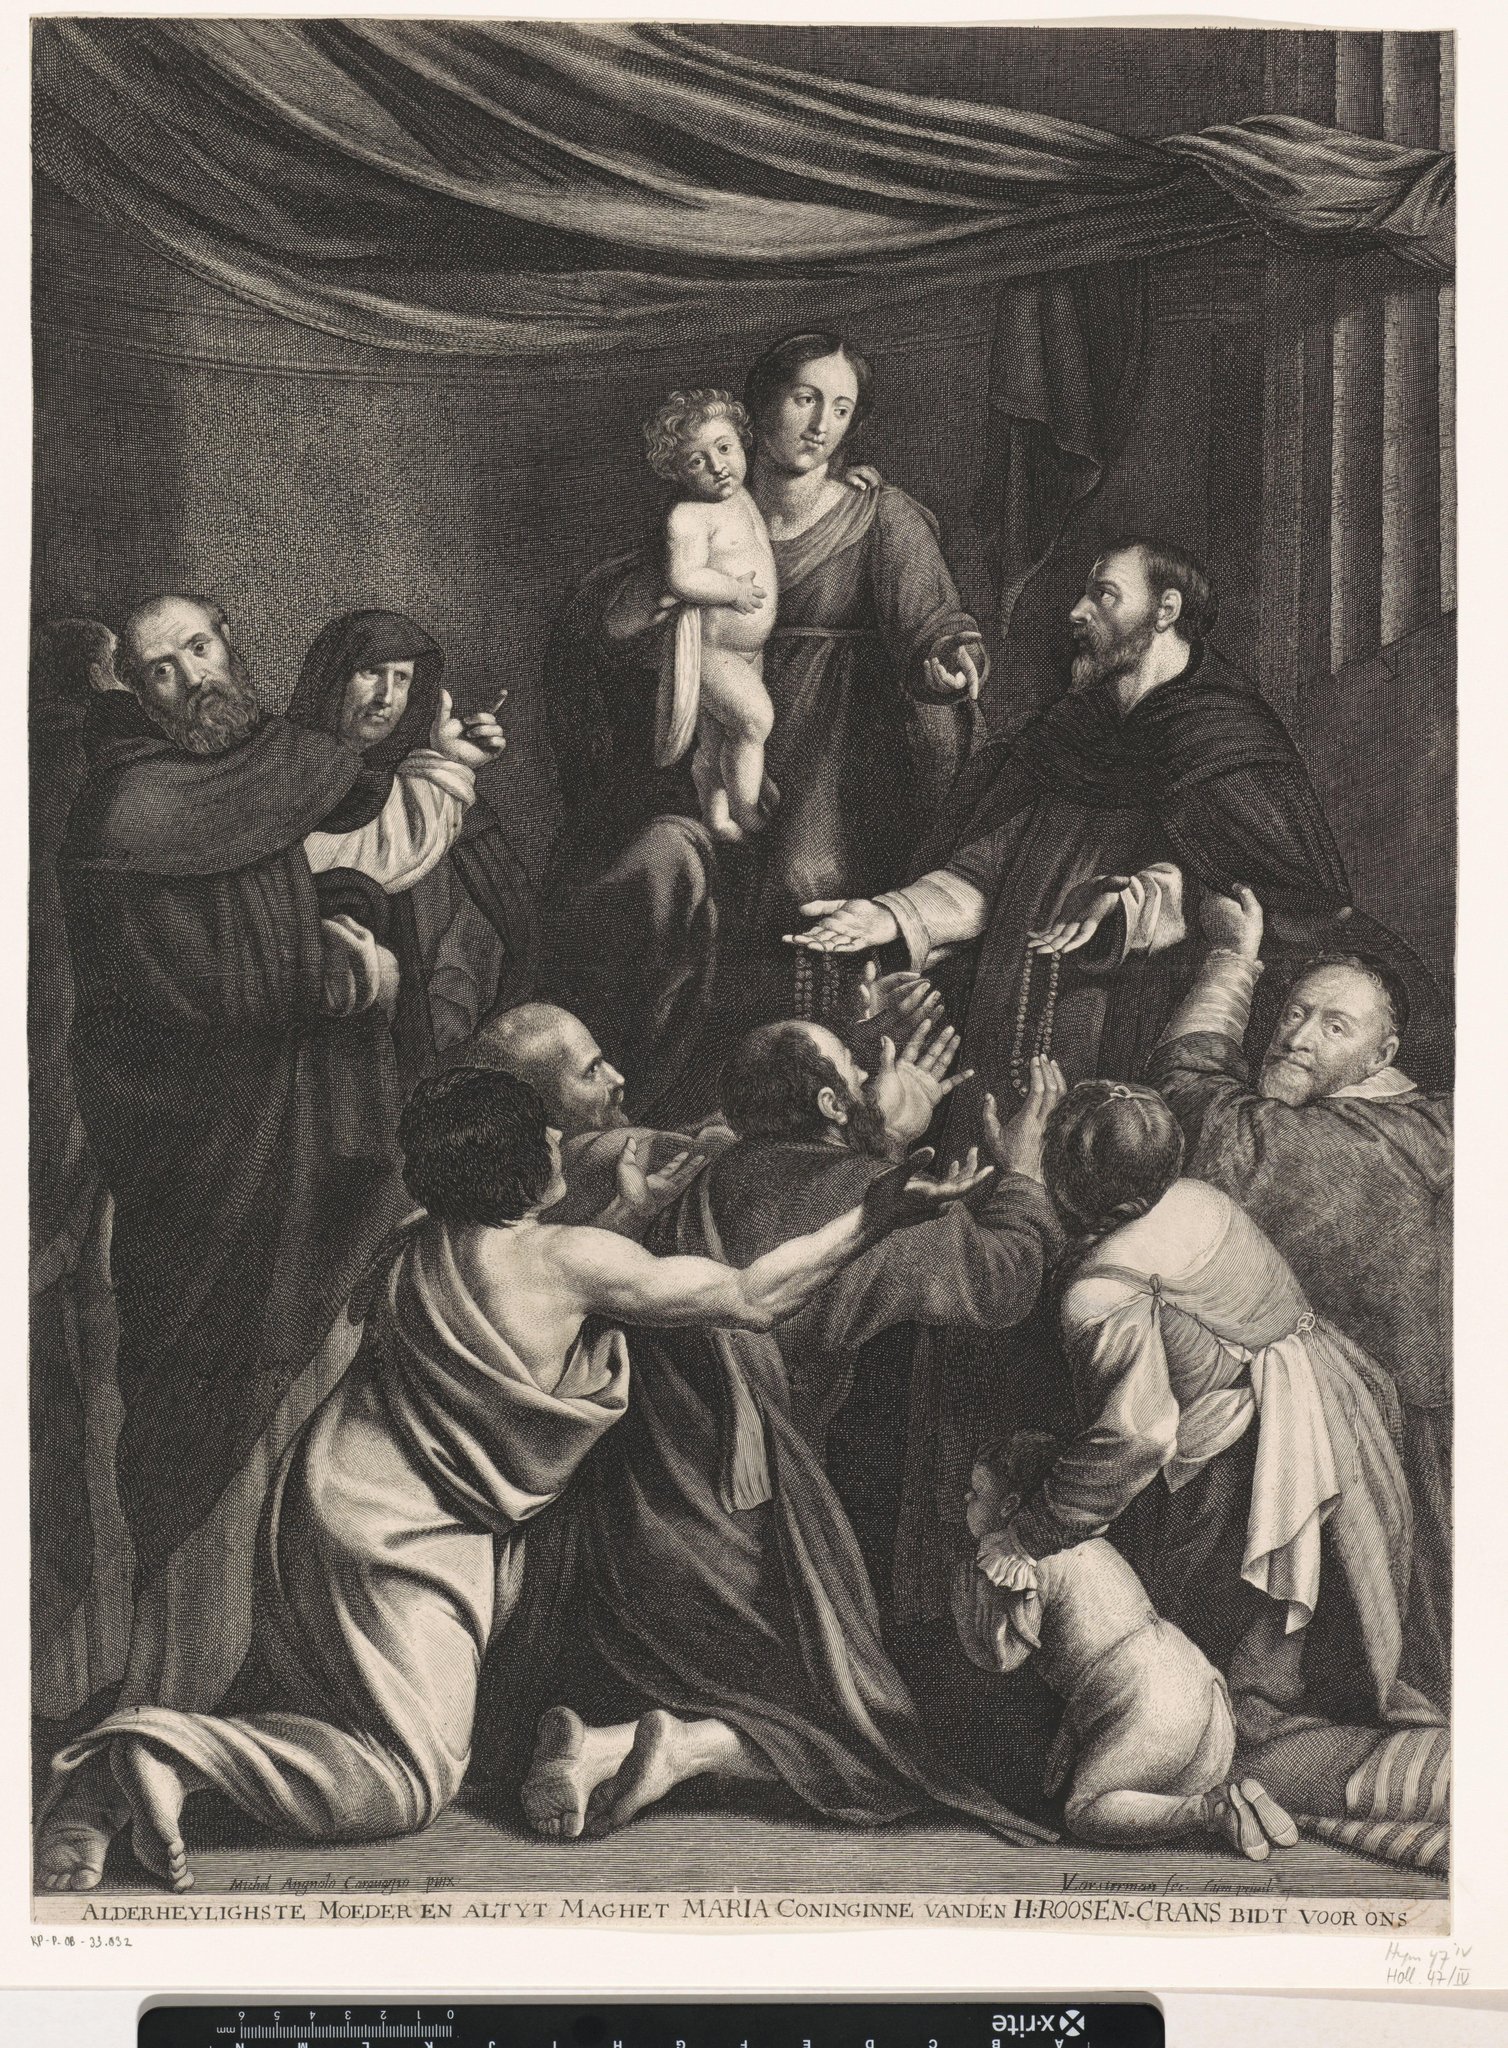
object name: print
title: Madonna van de Rozenkrans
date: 1619-1675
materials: paper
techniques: engraving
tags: madonna of the rosary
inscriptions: collector's mark: Lugt 240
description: Twee smekelingen aanbidden Maria met Kind, staand op een verhoging.